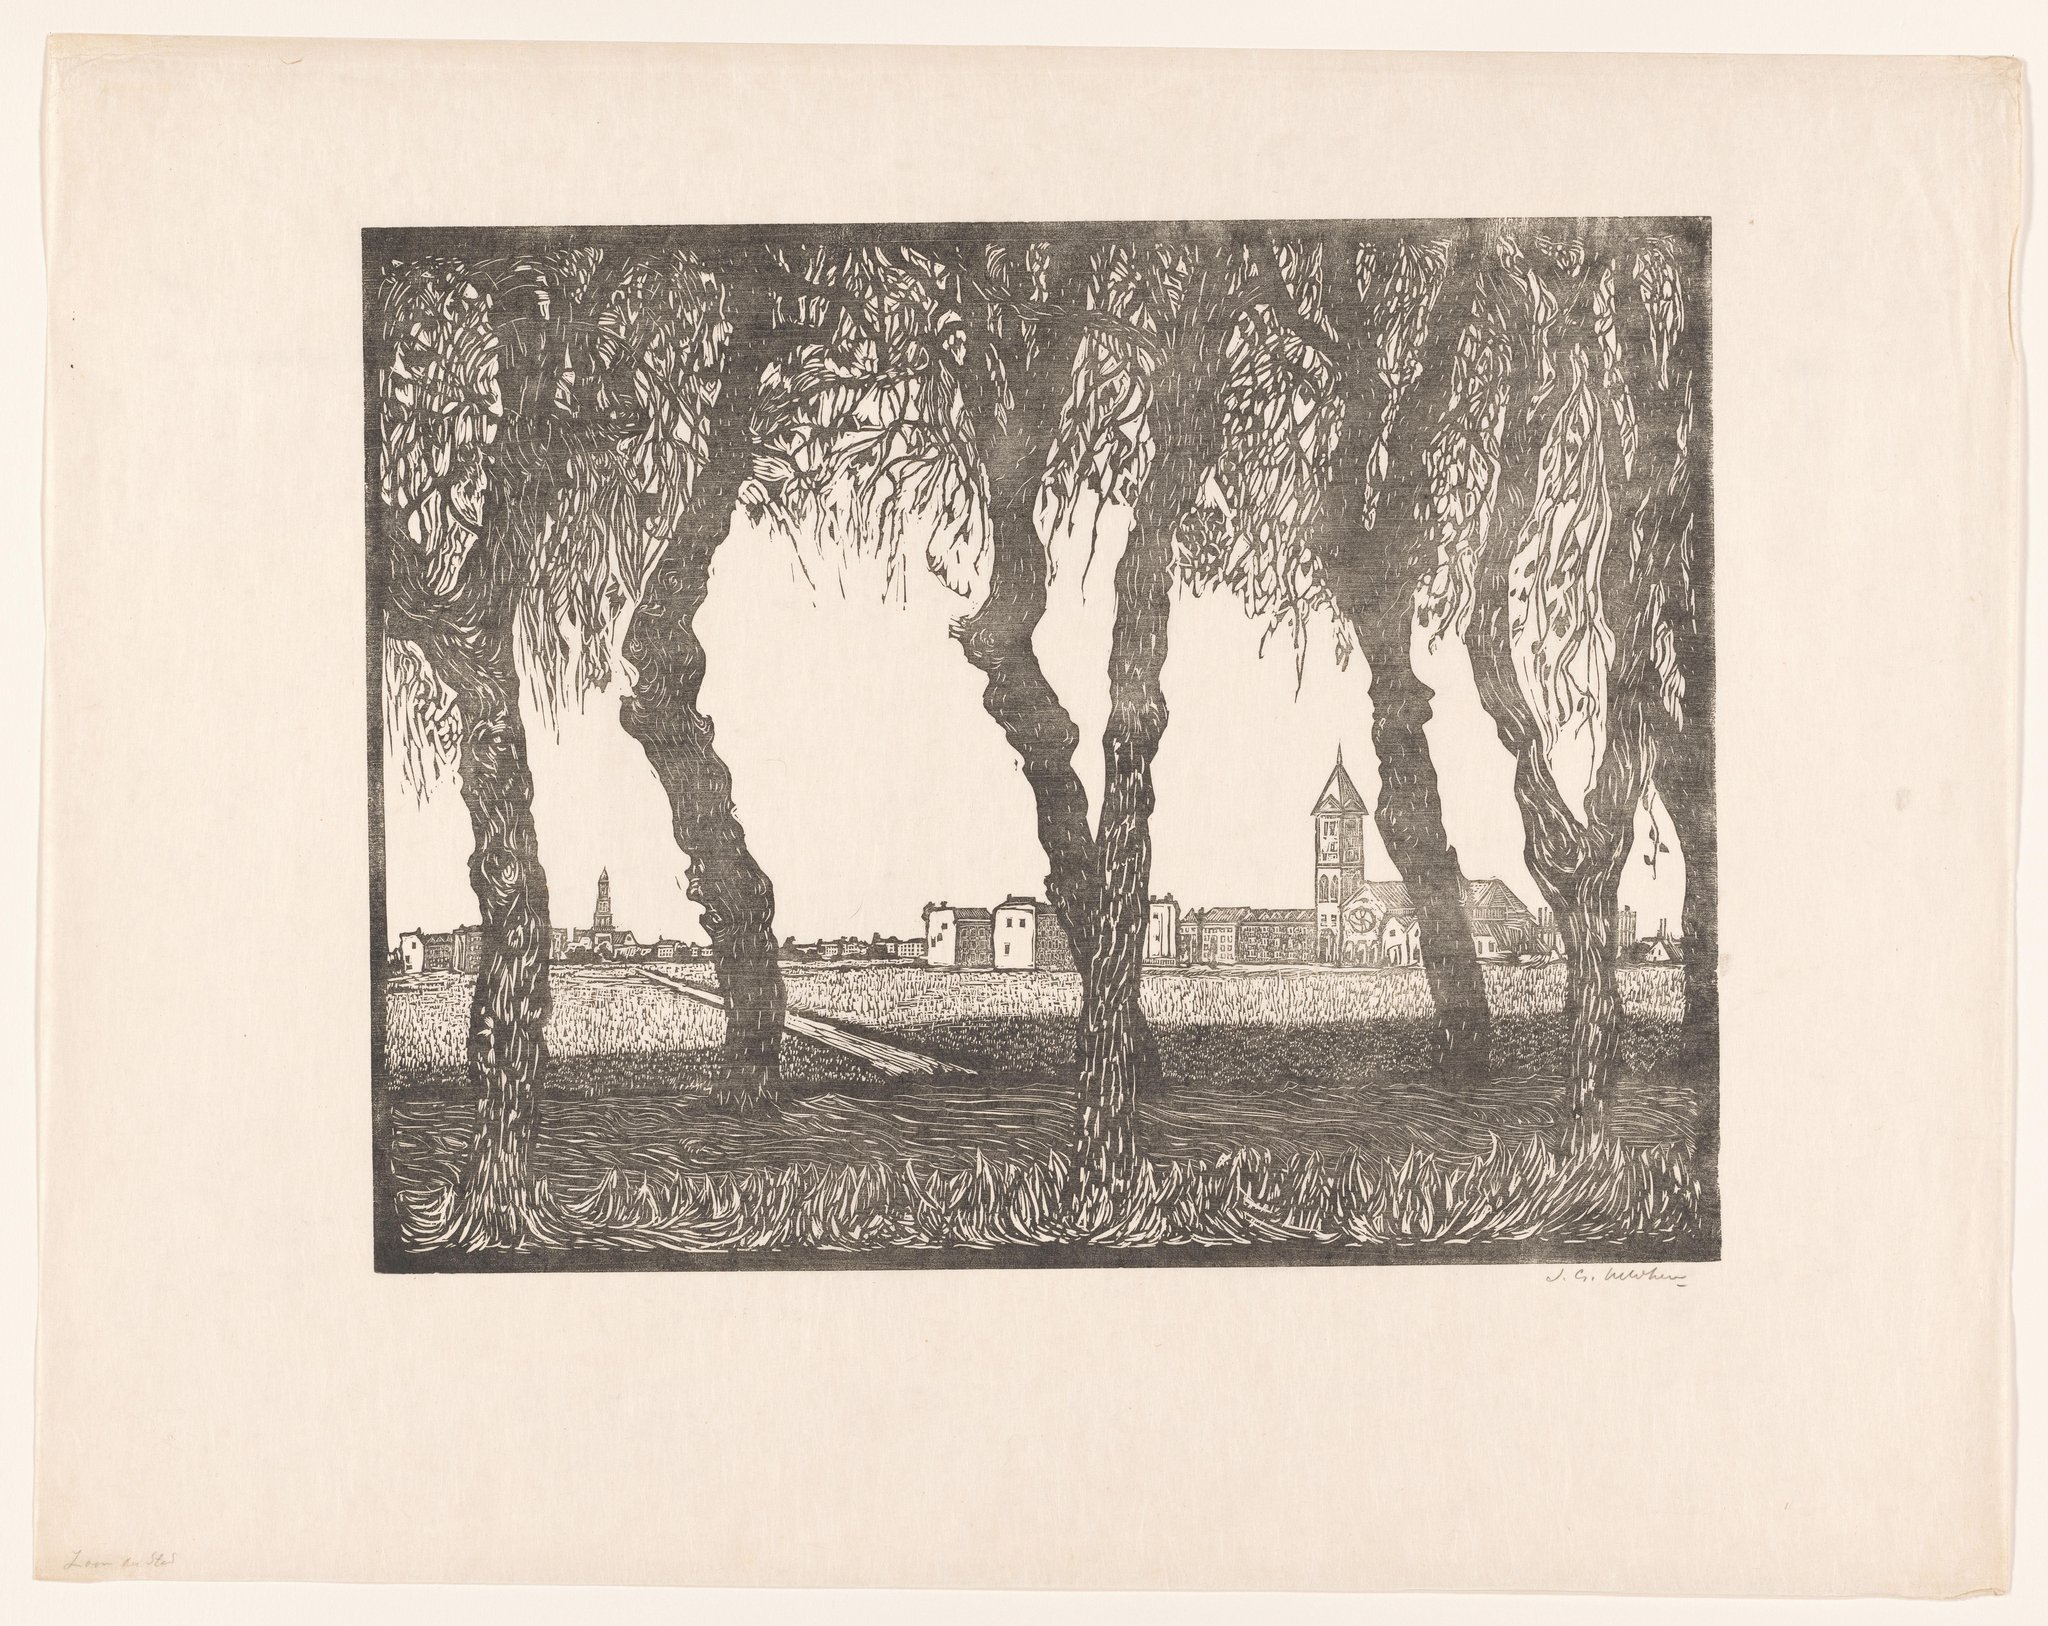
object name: print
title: Zoom der stad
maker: jacobus gerardus veldheer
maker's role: draughtsman, print maker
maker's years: 1866-1954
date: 1876-1916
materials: paper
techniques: woodcut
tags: city-view in general; 'veduta'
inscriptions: collector's mark: Lugt 2233